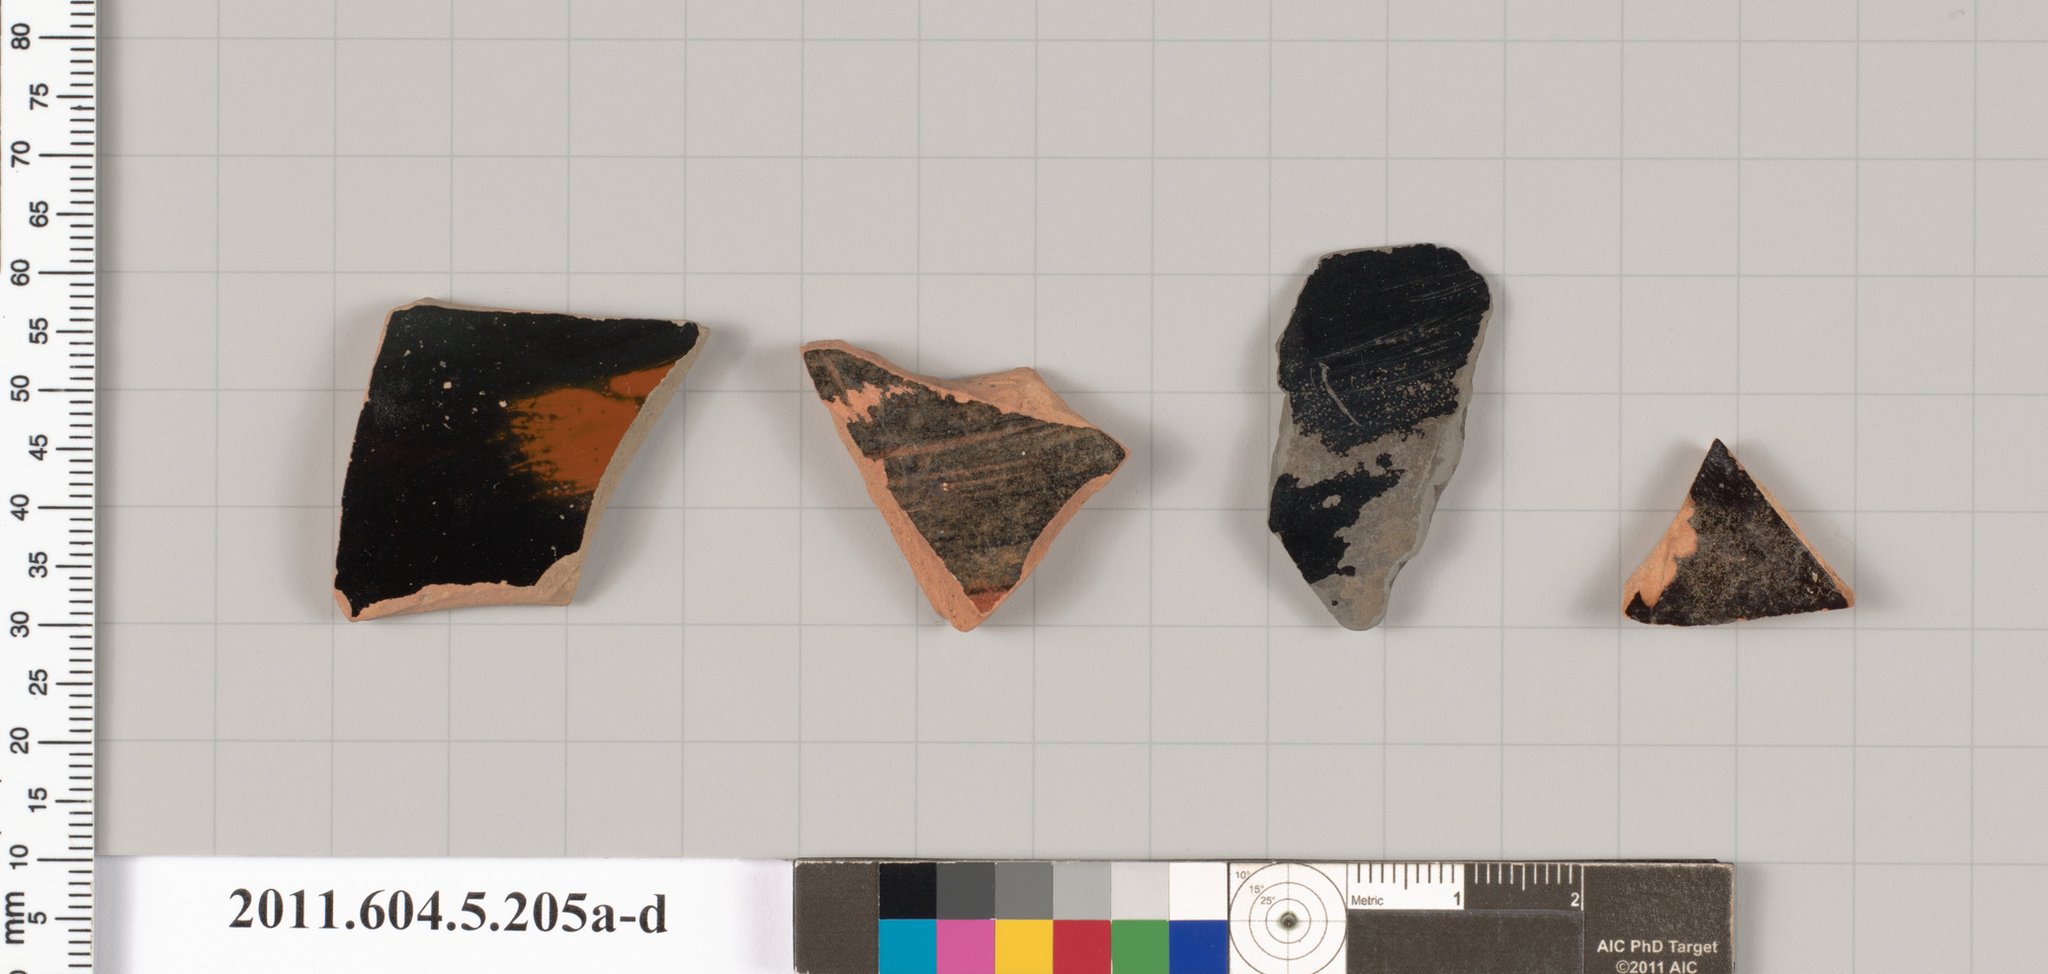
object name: kylix fragment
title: Terracotta fragments of kylikes (drinking cups)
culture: greek, attic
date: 600-401 BCE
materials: terracotta